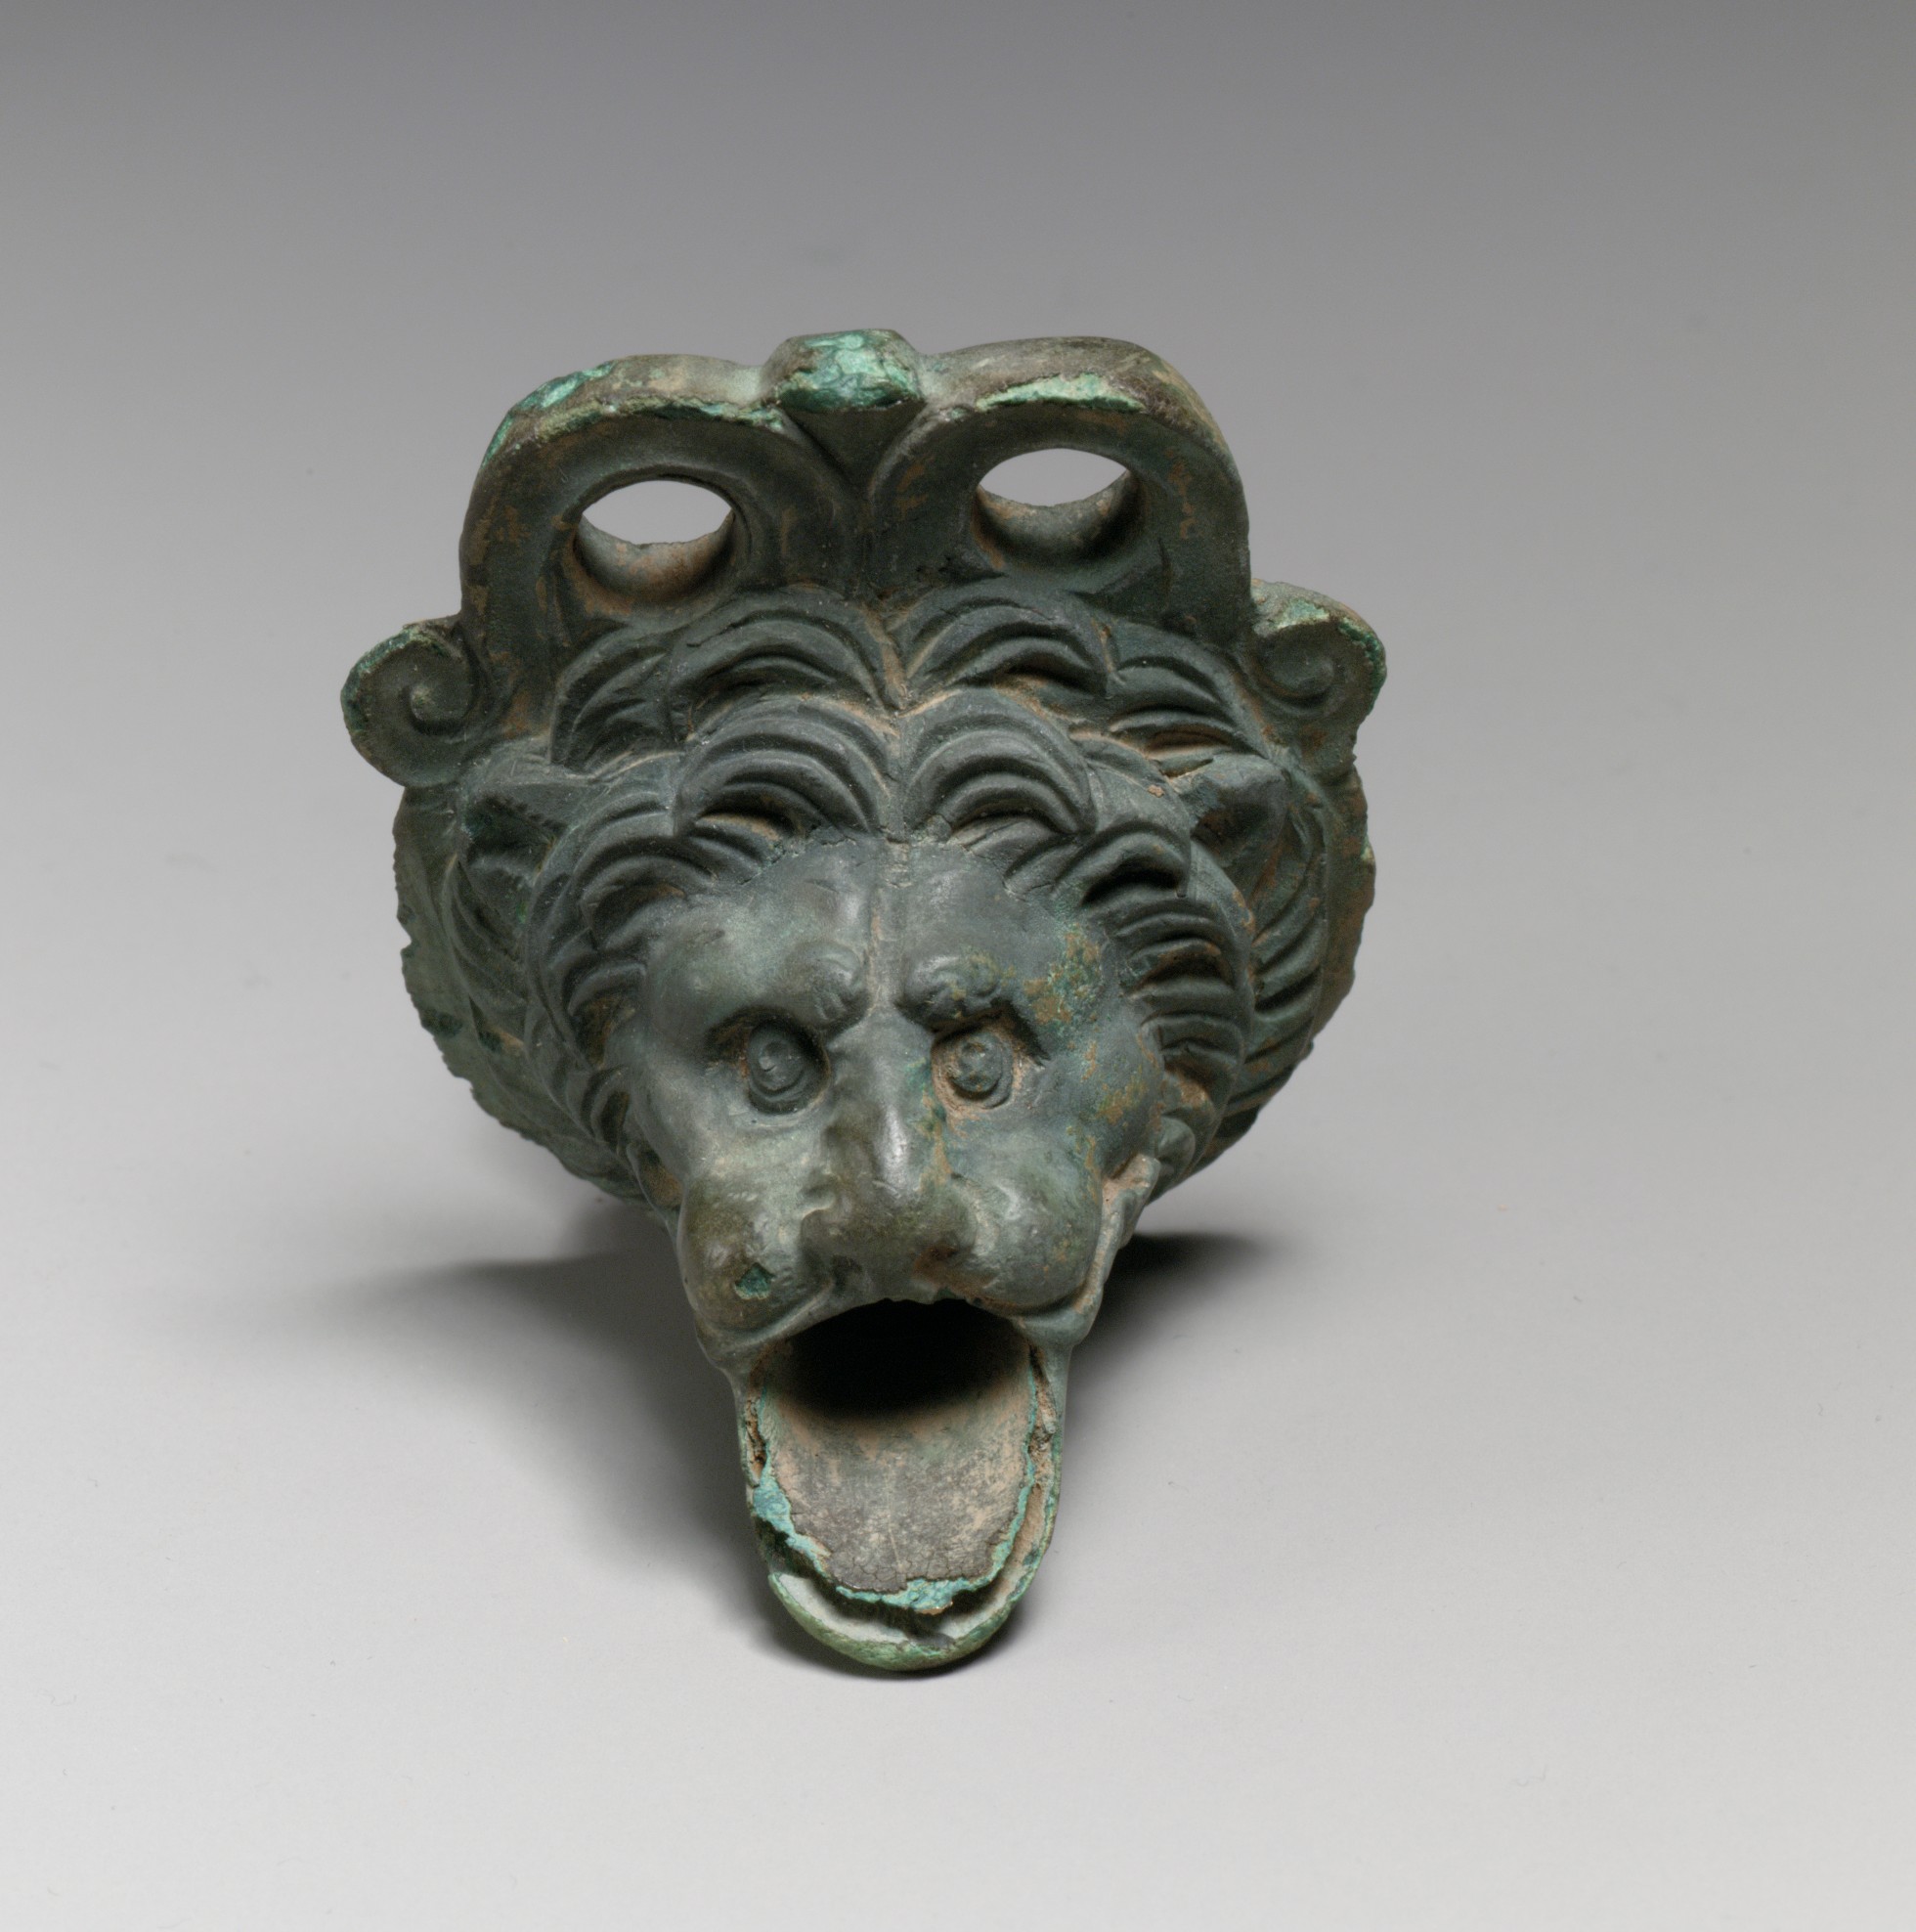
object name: spout with lion mask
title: Bronze spout in the form of a lion's head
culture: greek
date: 400-301 BCE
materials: bronze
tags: lions